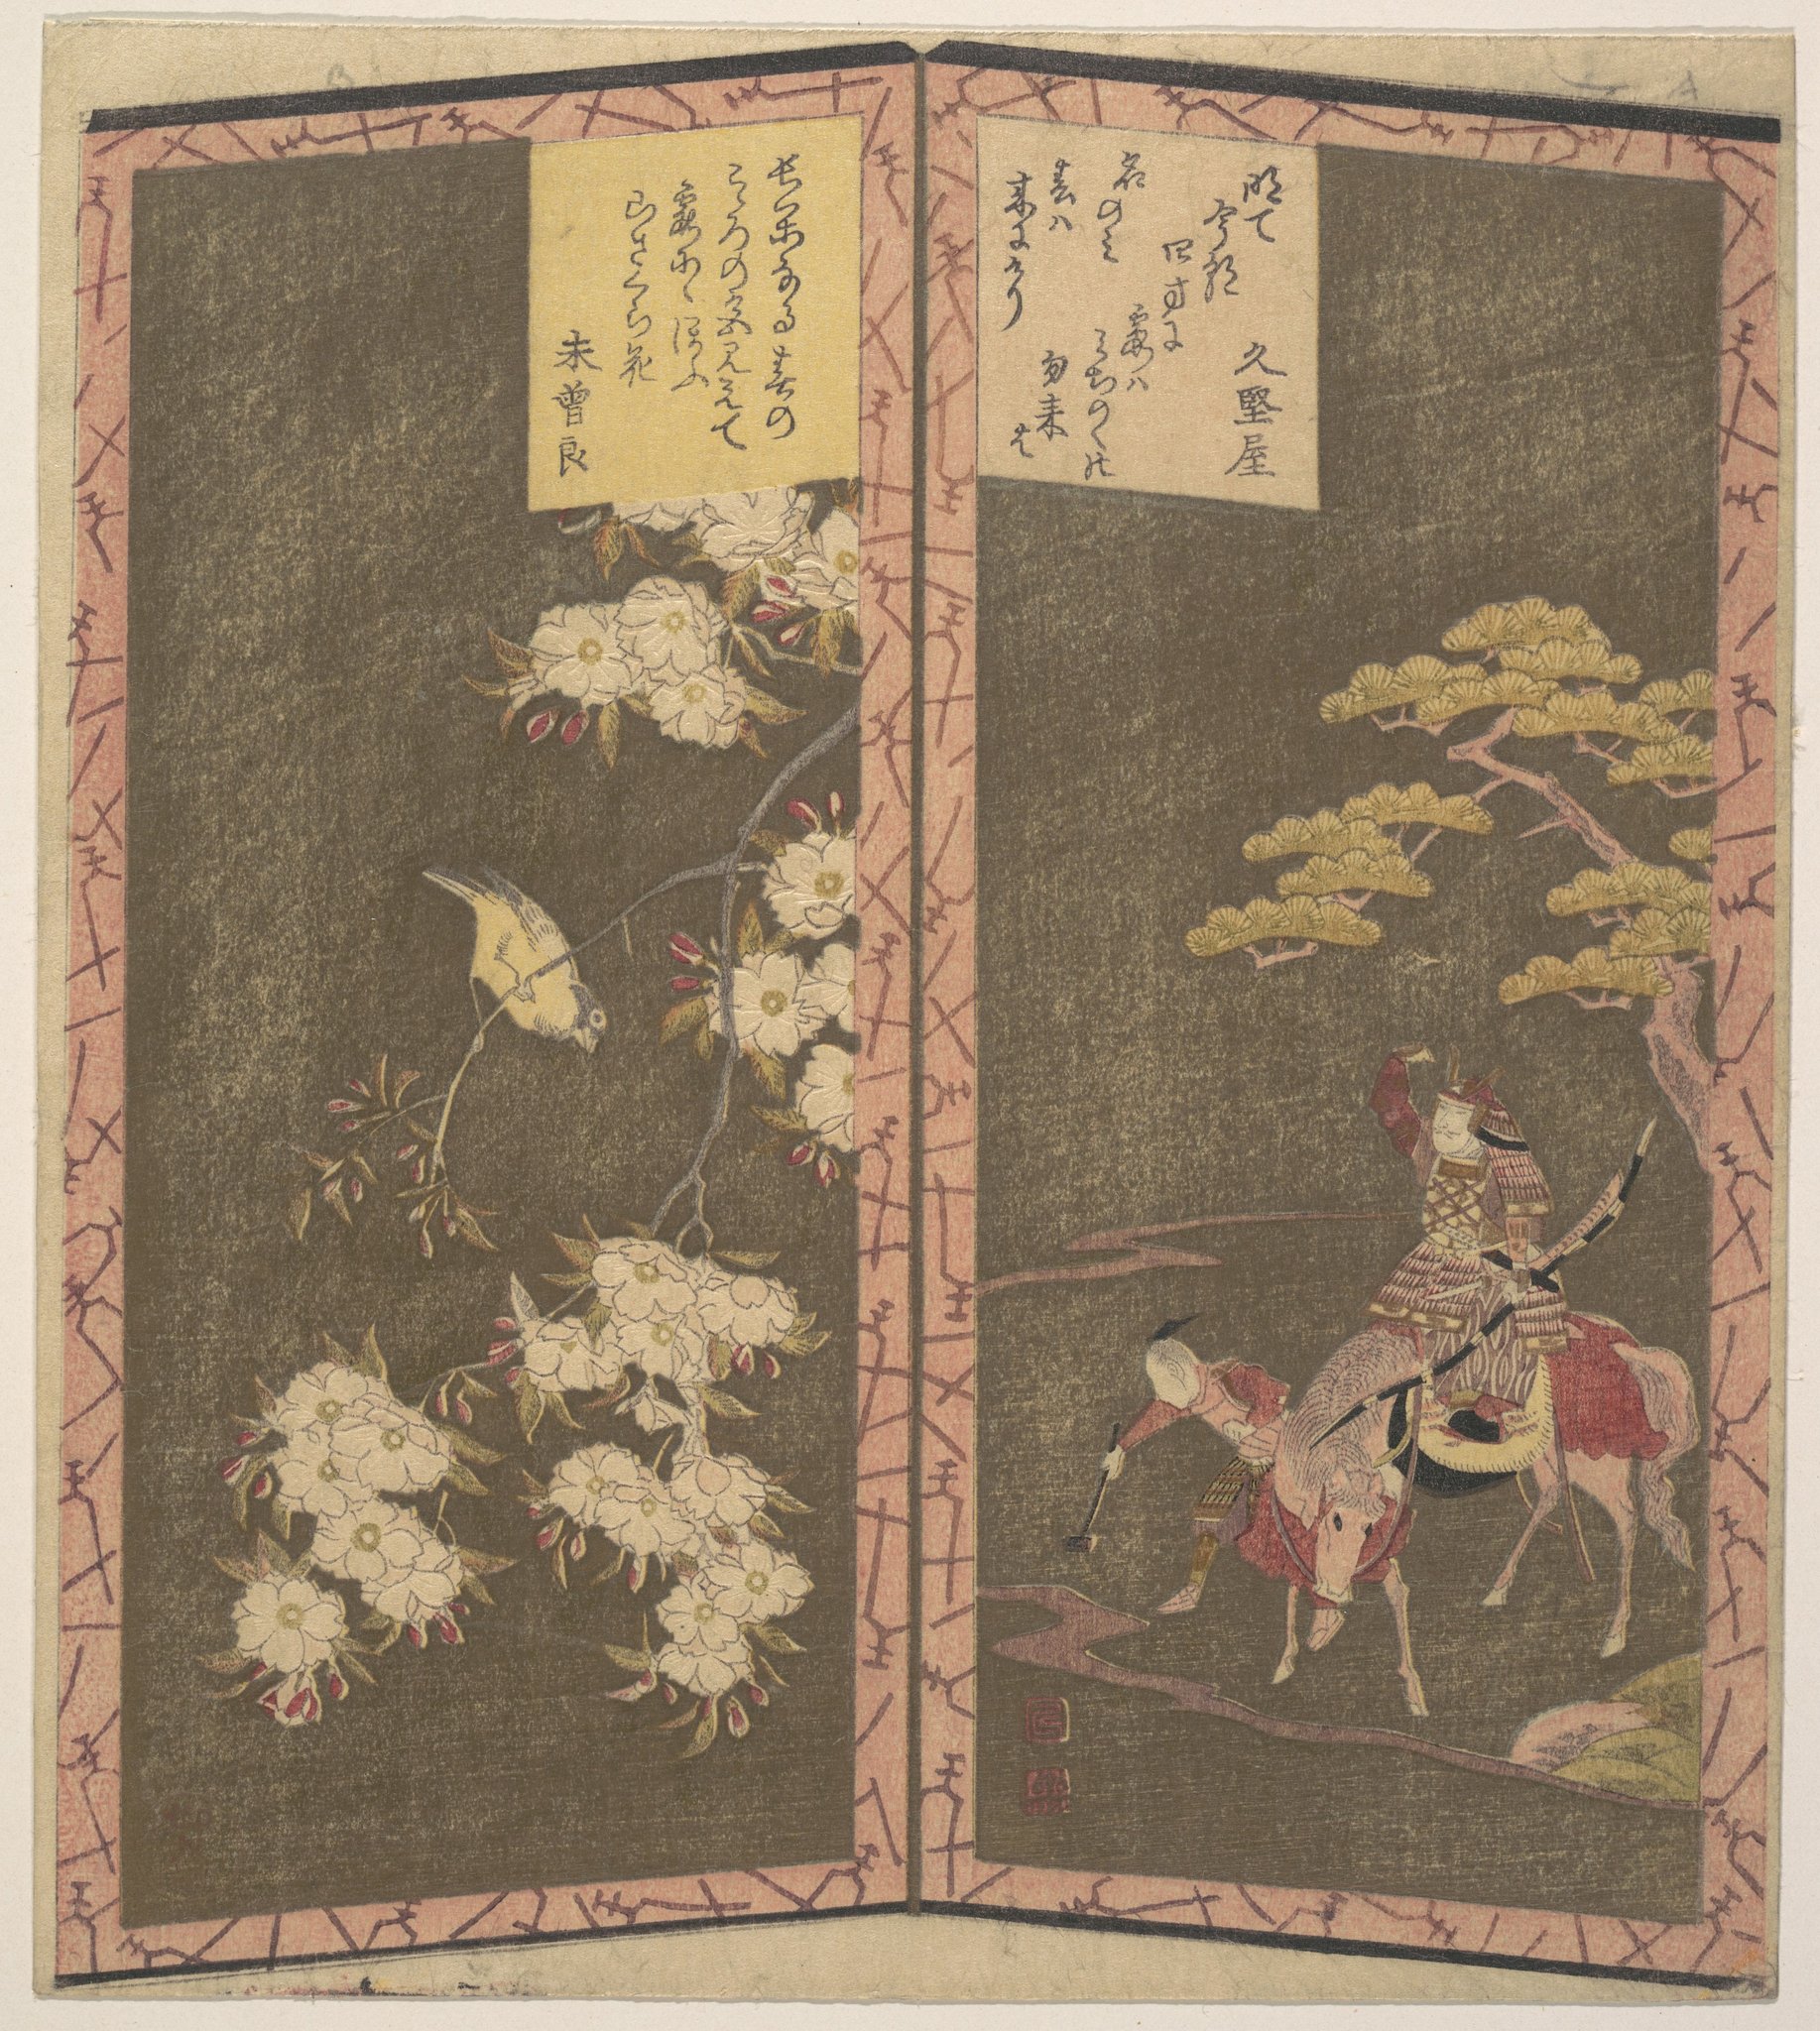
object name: woodblock print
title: Left: Bird on Branch of a Cherry Tree; Right: Minamotono Yoshiié on Horseback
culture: japanese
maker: ryūryūkyo shinsai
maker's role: artist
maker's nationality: japanese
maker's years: 1799-1823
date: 1750-1835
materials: ink, paper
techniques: surimono, woodblock print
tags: birds,horses,flowers,trees